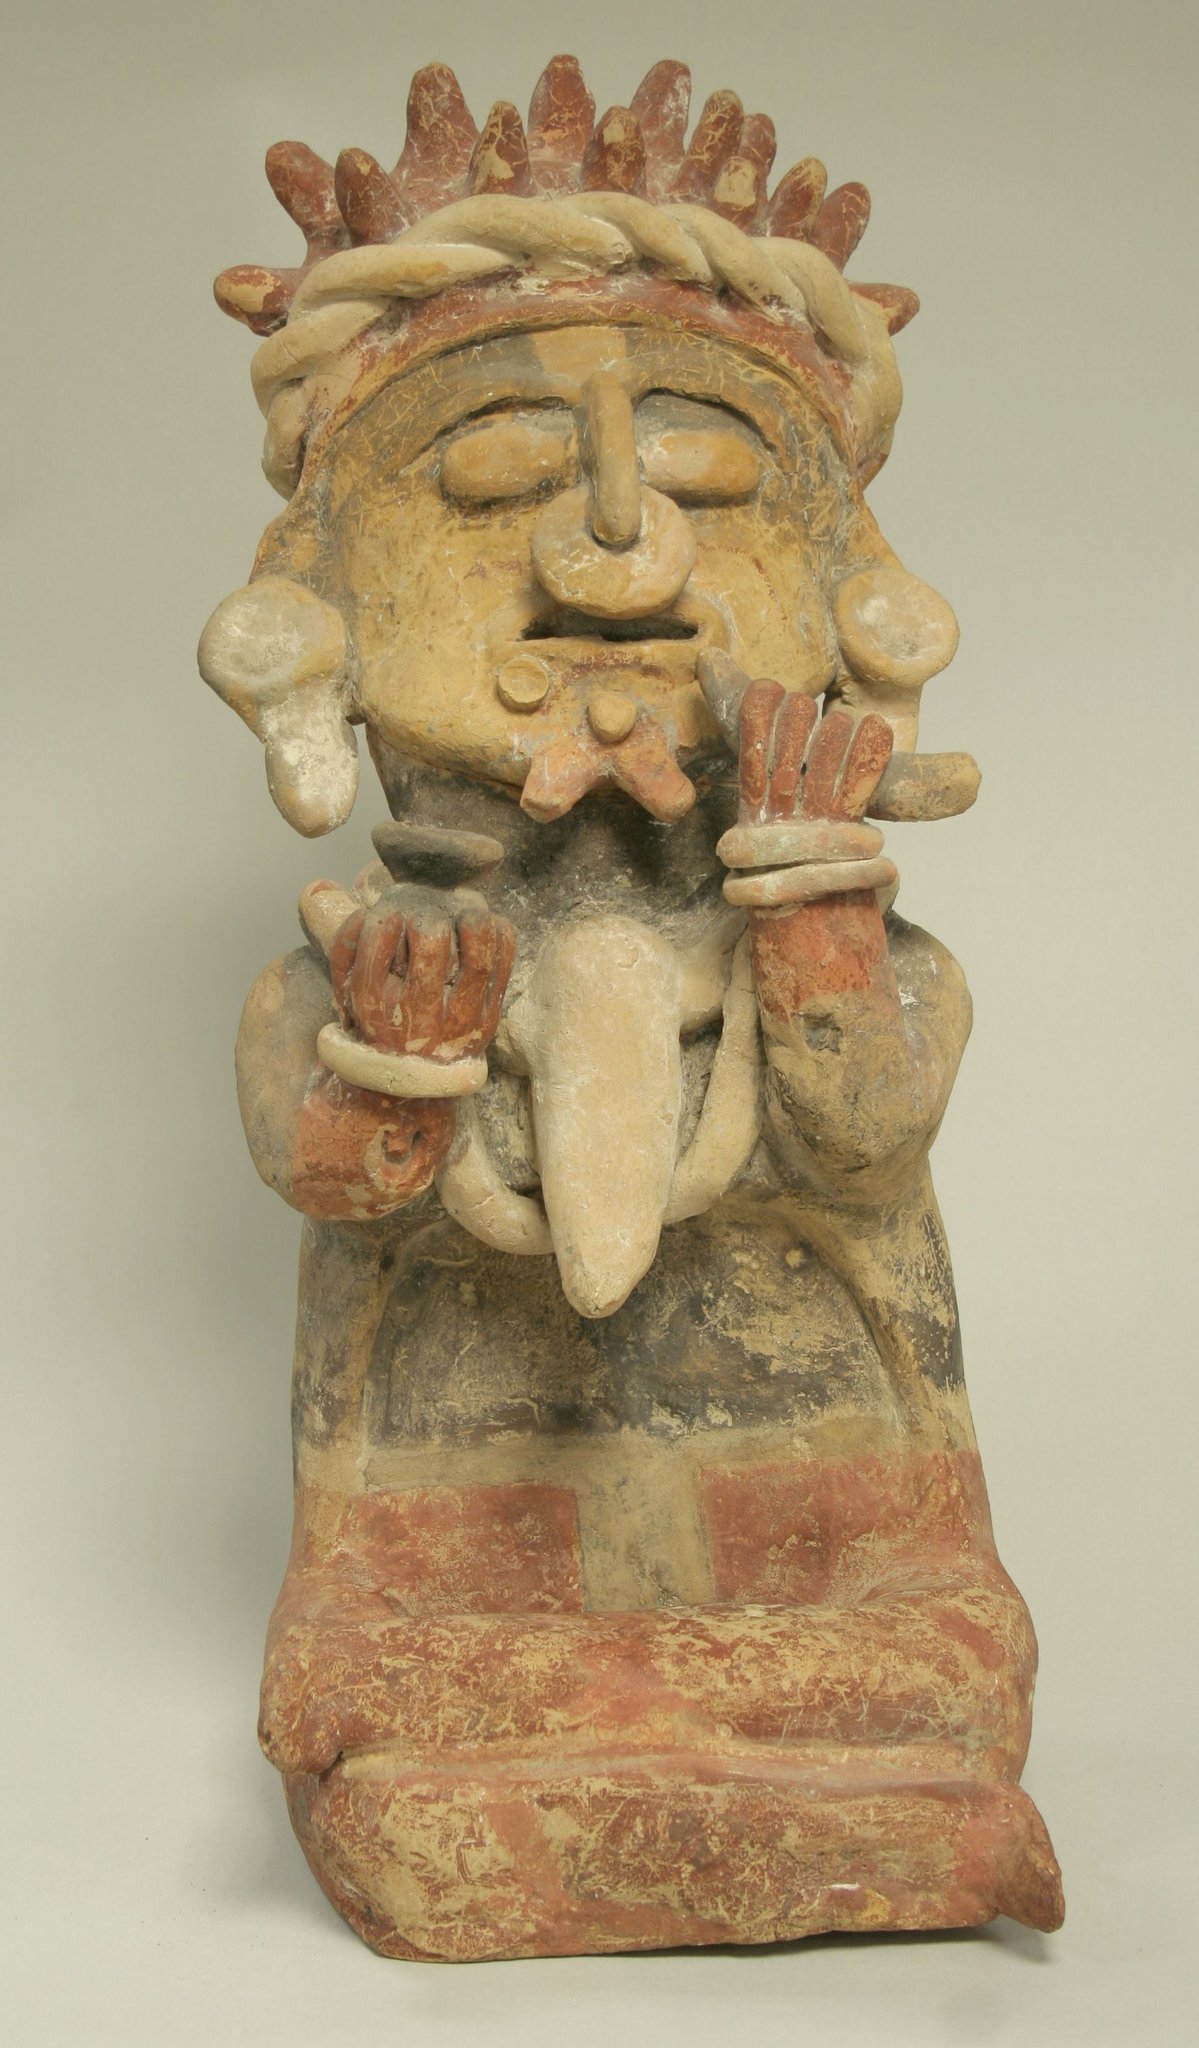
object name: vessel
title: Seated Figure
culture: bahian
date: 1-500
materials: ceramic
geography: ecuador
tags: human figures